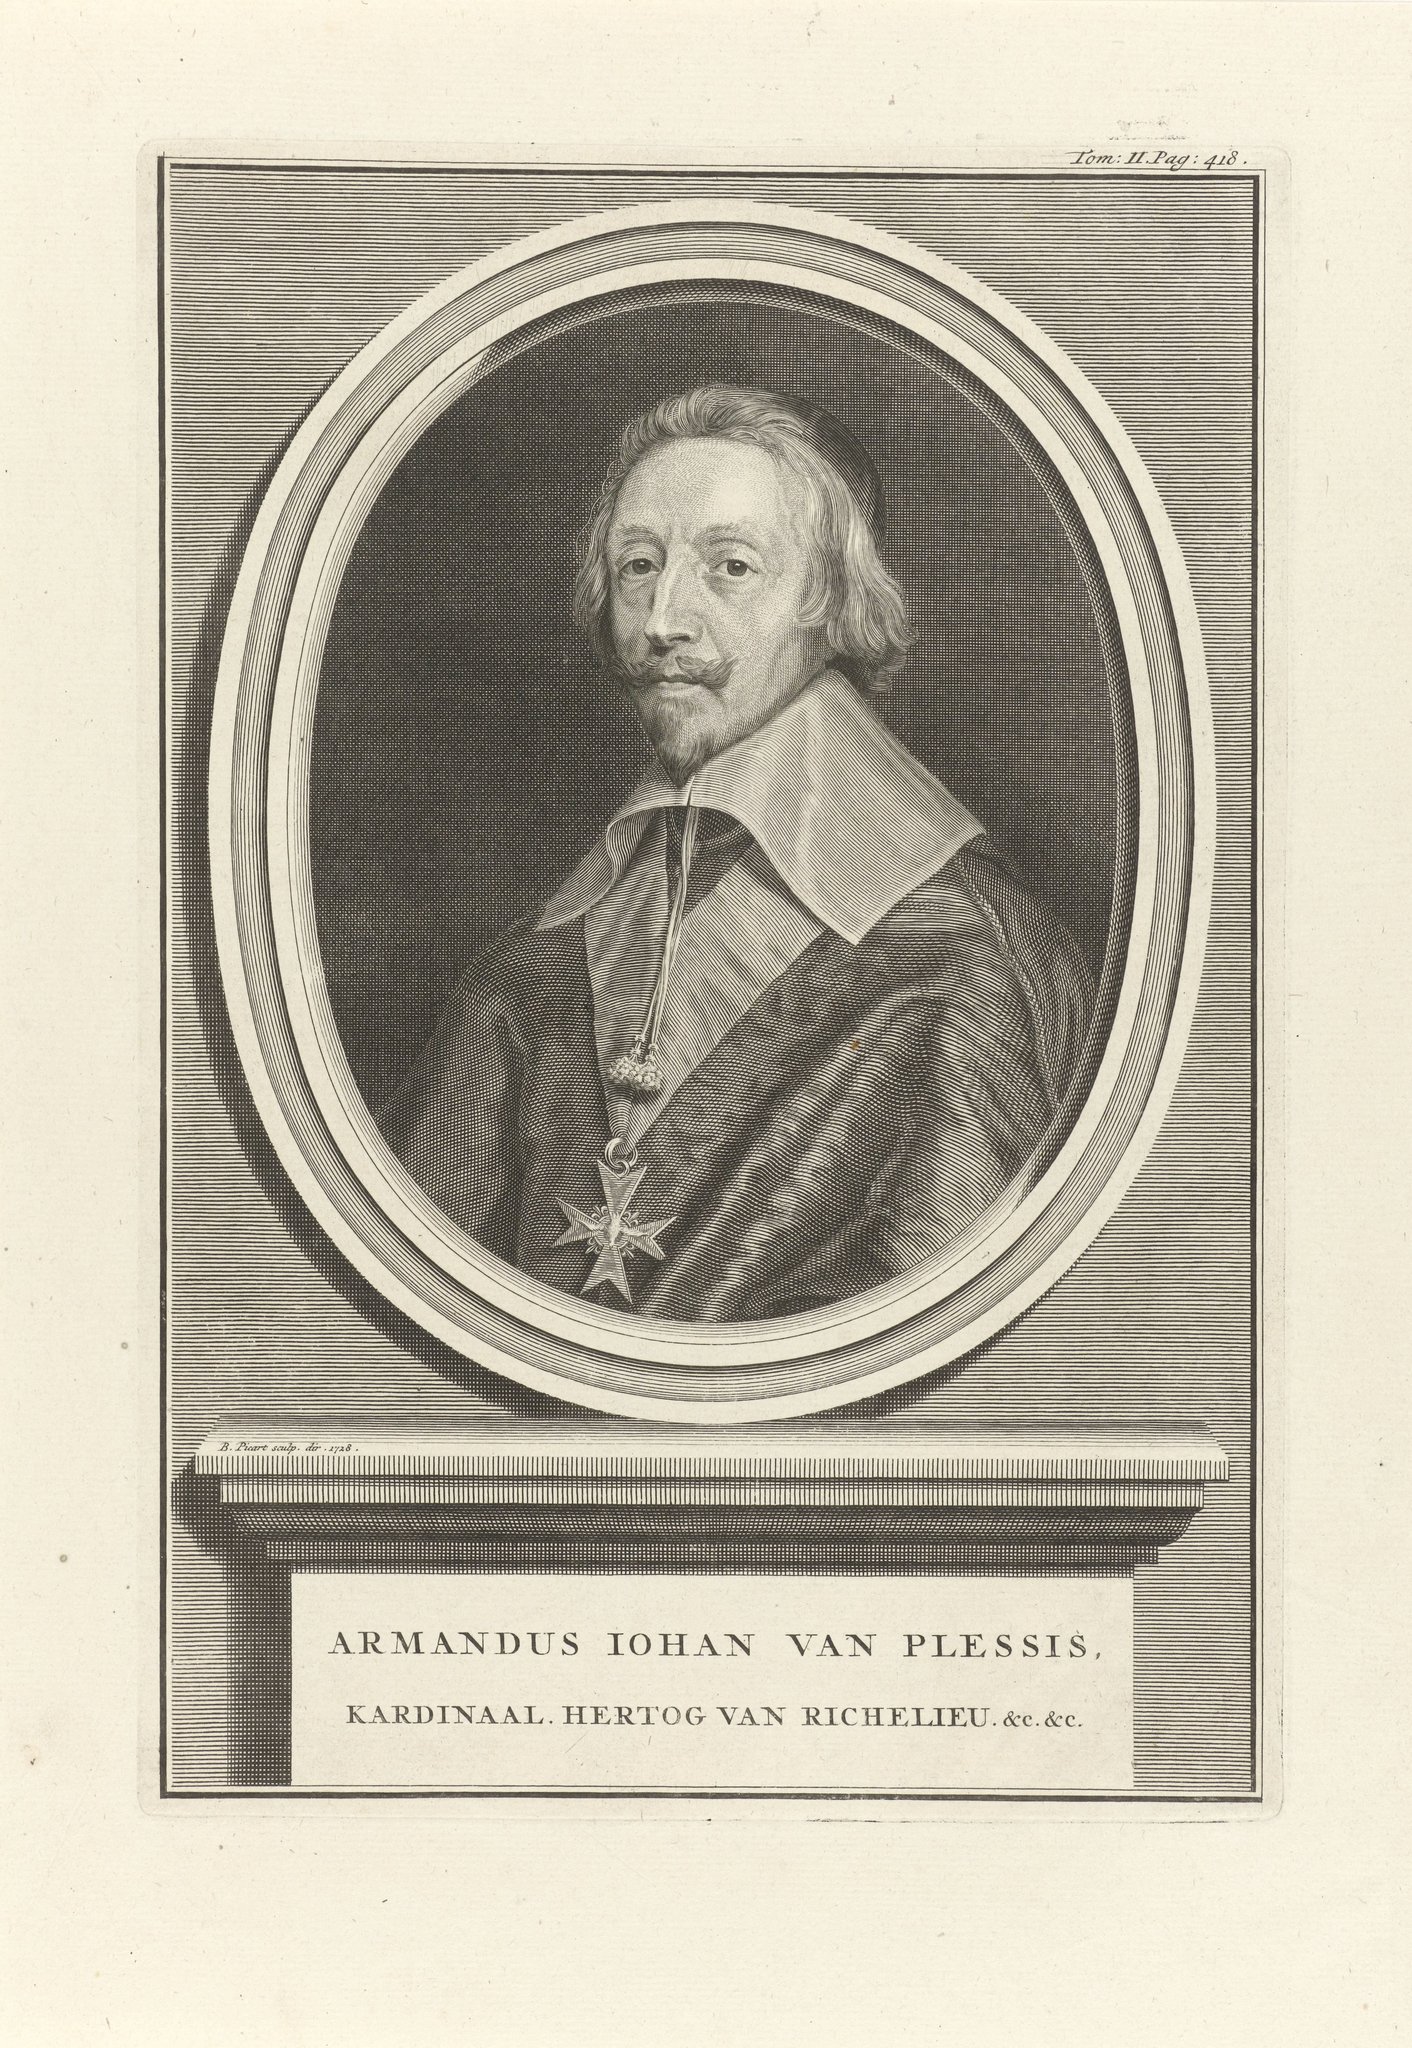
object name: print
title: Portret van kardinaal Armand-Jean du Plessis, hertog van Richelieu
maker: bernard picart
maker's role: draughtsman, print maker, publisher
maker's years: 1673-1733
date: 1728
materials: paper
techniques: engraving, etching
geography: amsterdam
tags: armand-jean du plessis hertog van richelieu, knighthood order of the holy spirit, insignia of cardinal, e.g. hat, mantle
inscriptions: collector's mark: Lugt 2228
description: Prent als illustratie gebruikt in: Le Clerc, Jean. Geschiedenissen der Vereenigde Nederlanden. Amsterdam: Zacharias Chatelain (II), 1730.